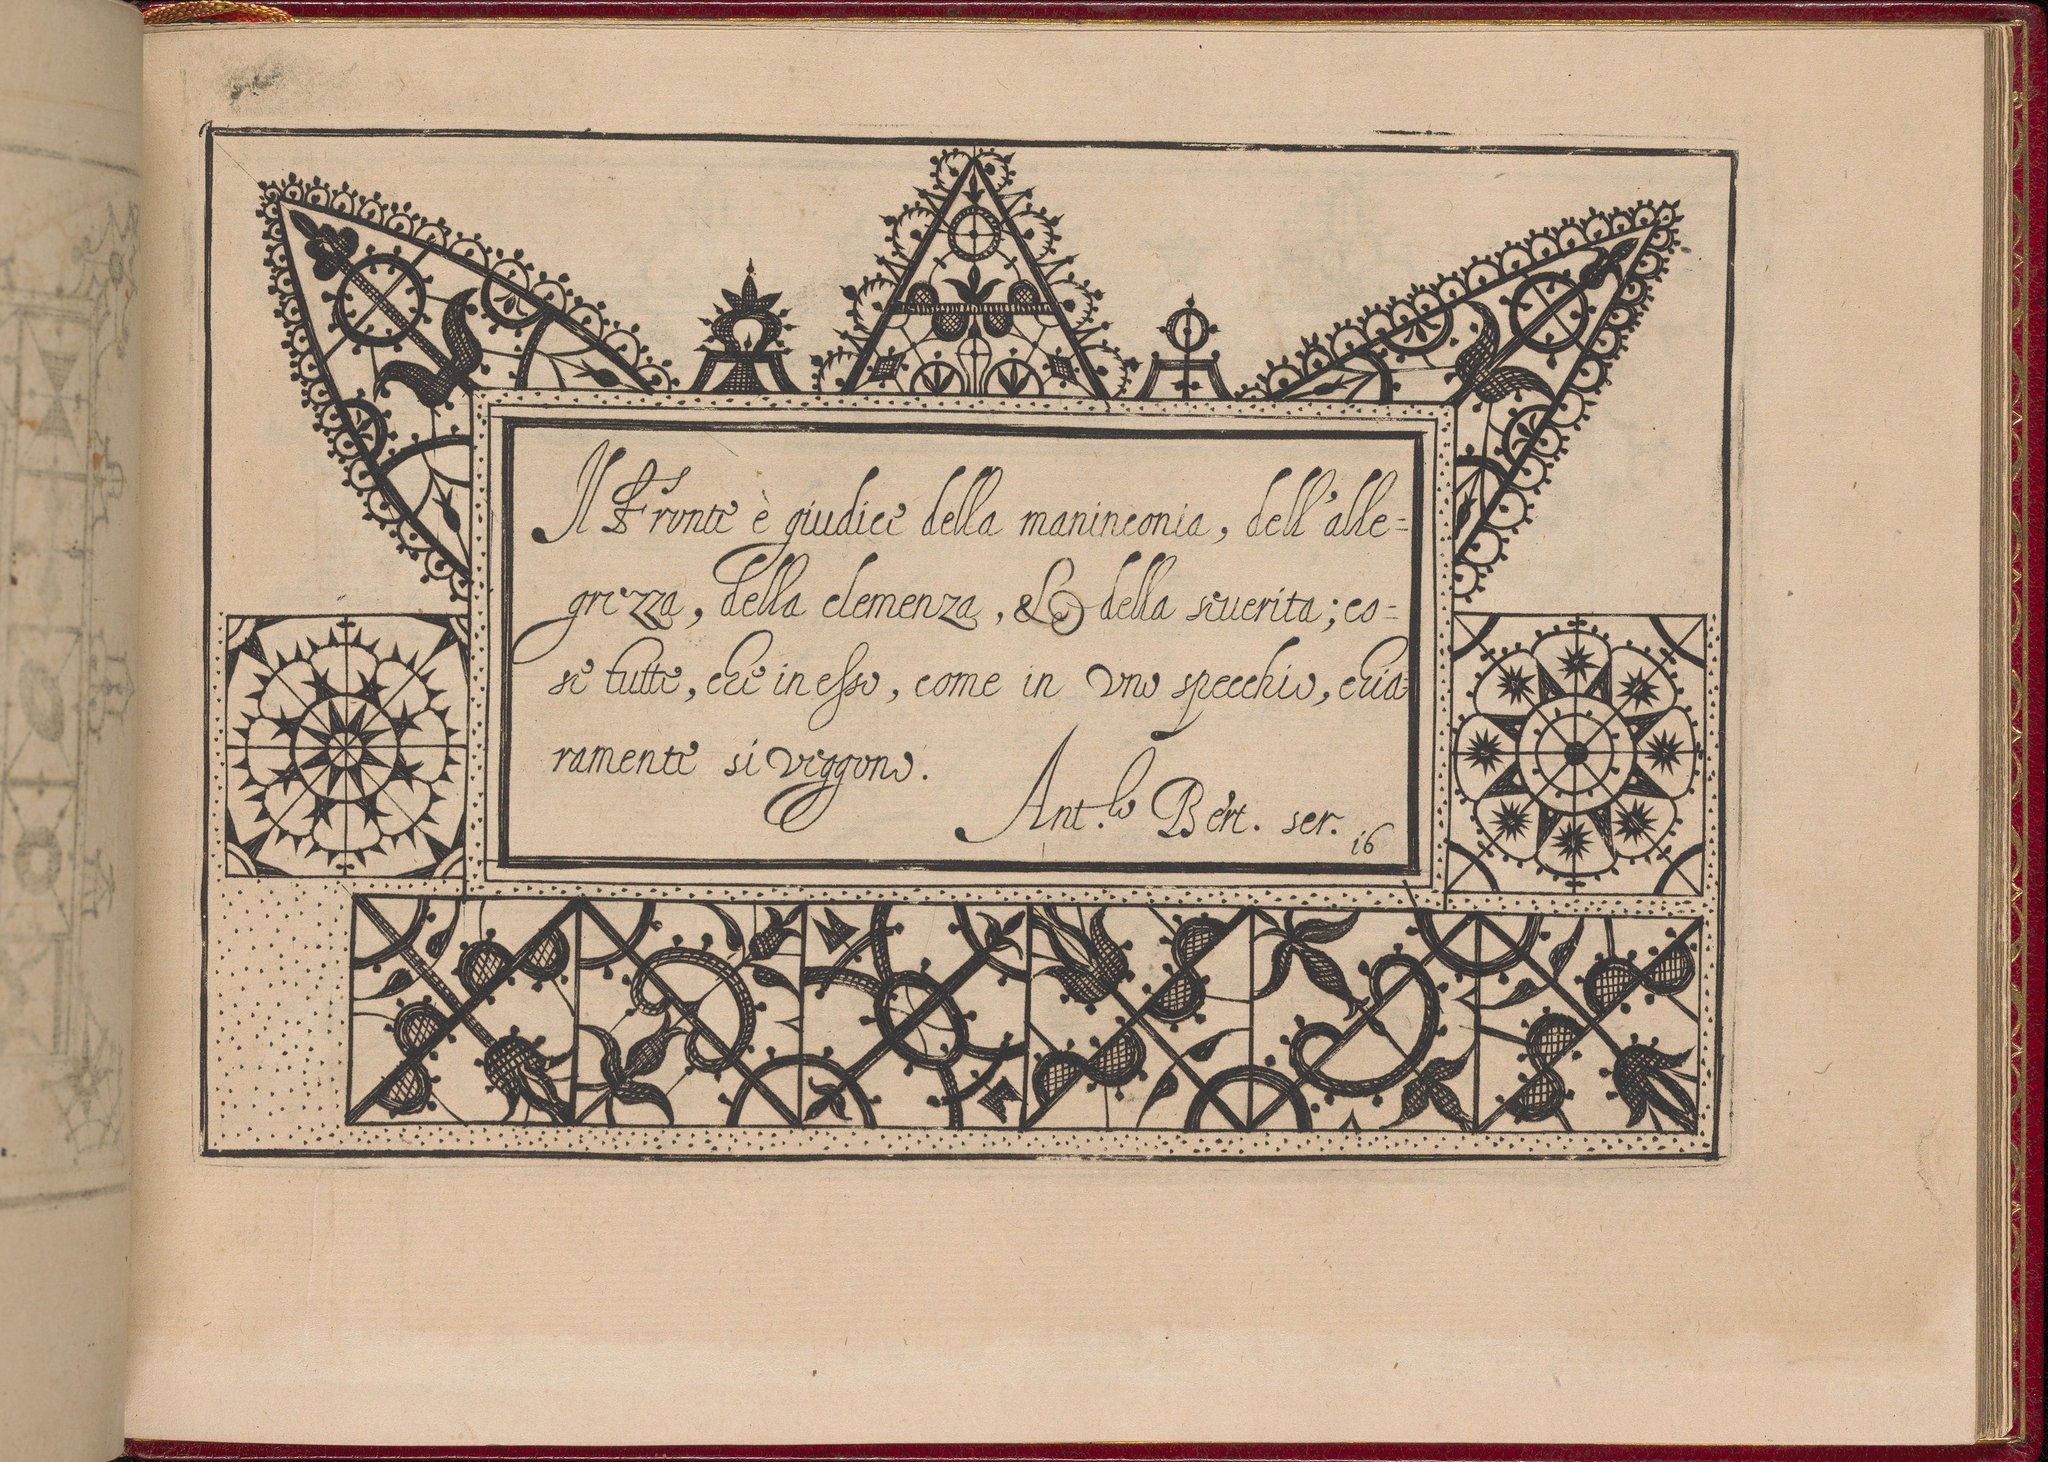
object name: book print ornament architecture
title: Ghirlanda: Di sei vaghi fiori scielti da piu famosi Giardini d'Italia, page 24 (recto)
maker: pietro paulo tozzi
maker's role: designer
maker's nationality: italian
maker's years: 1593-1628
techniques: drawing, etching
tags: ornament